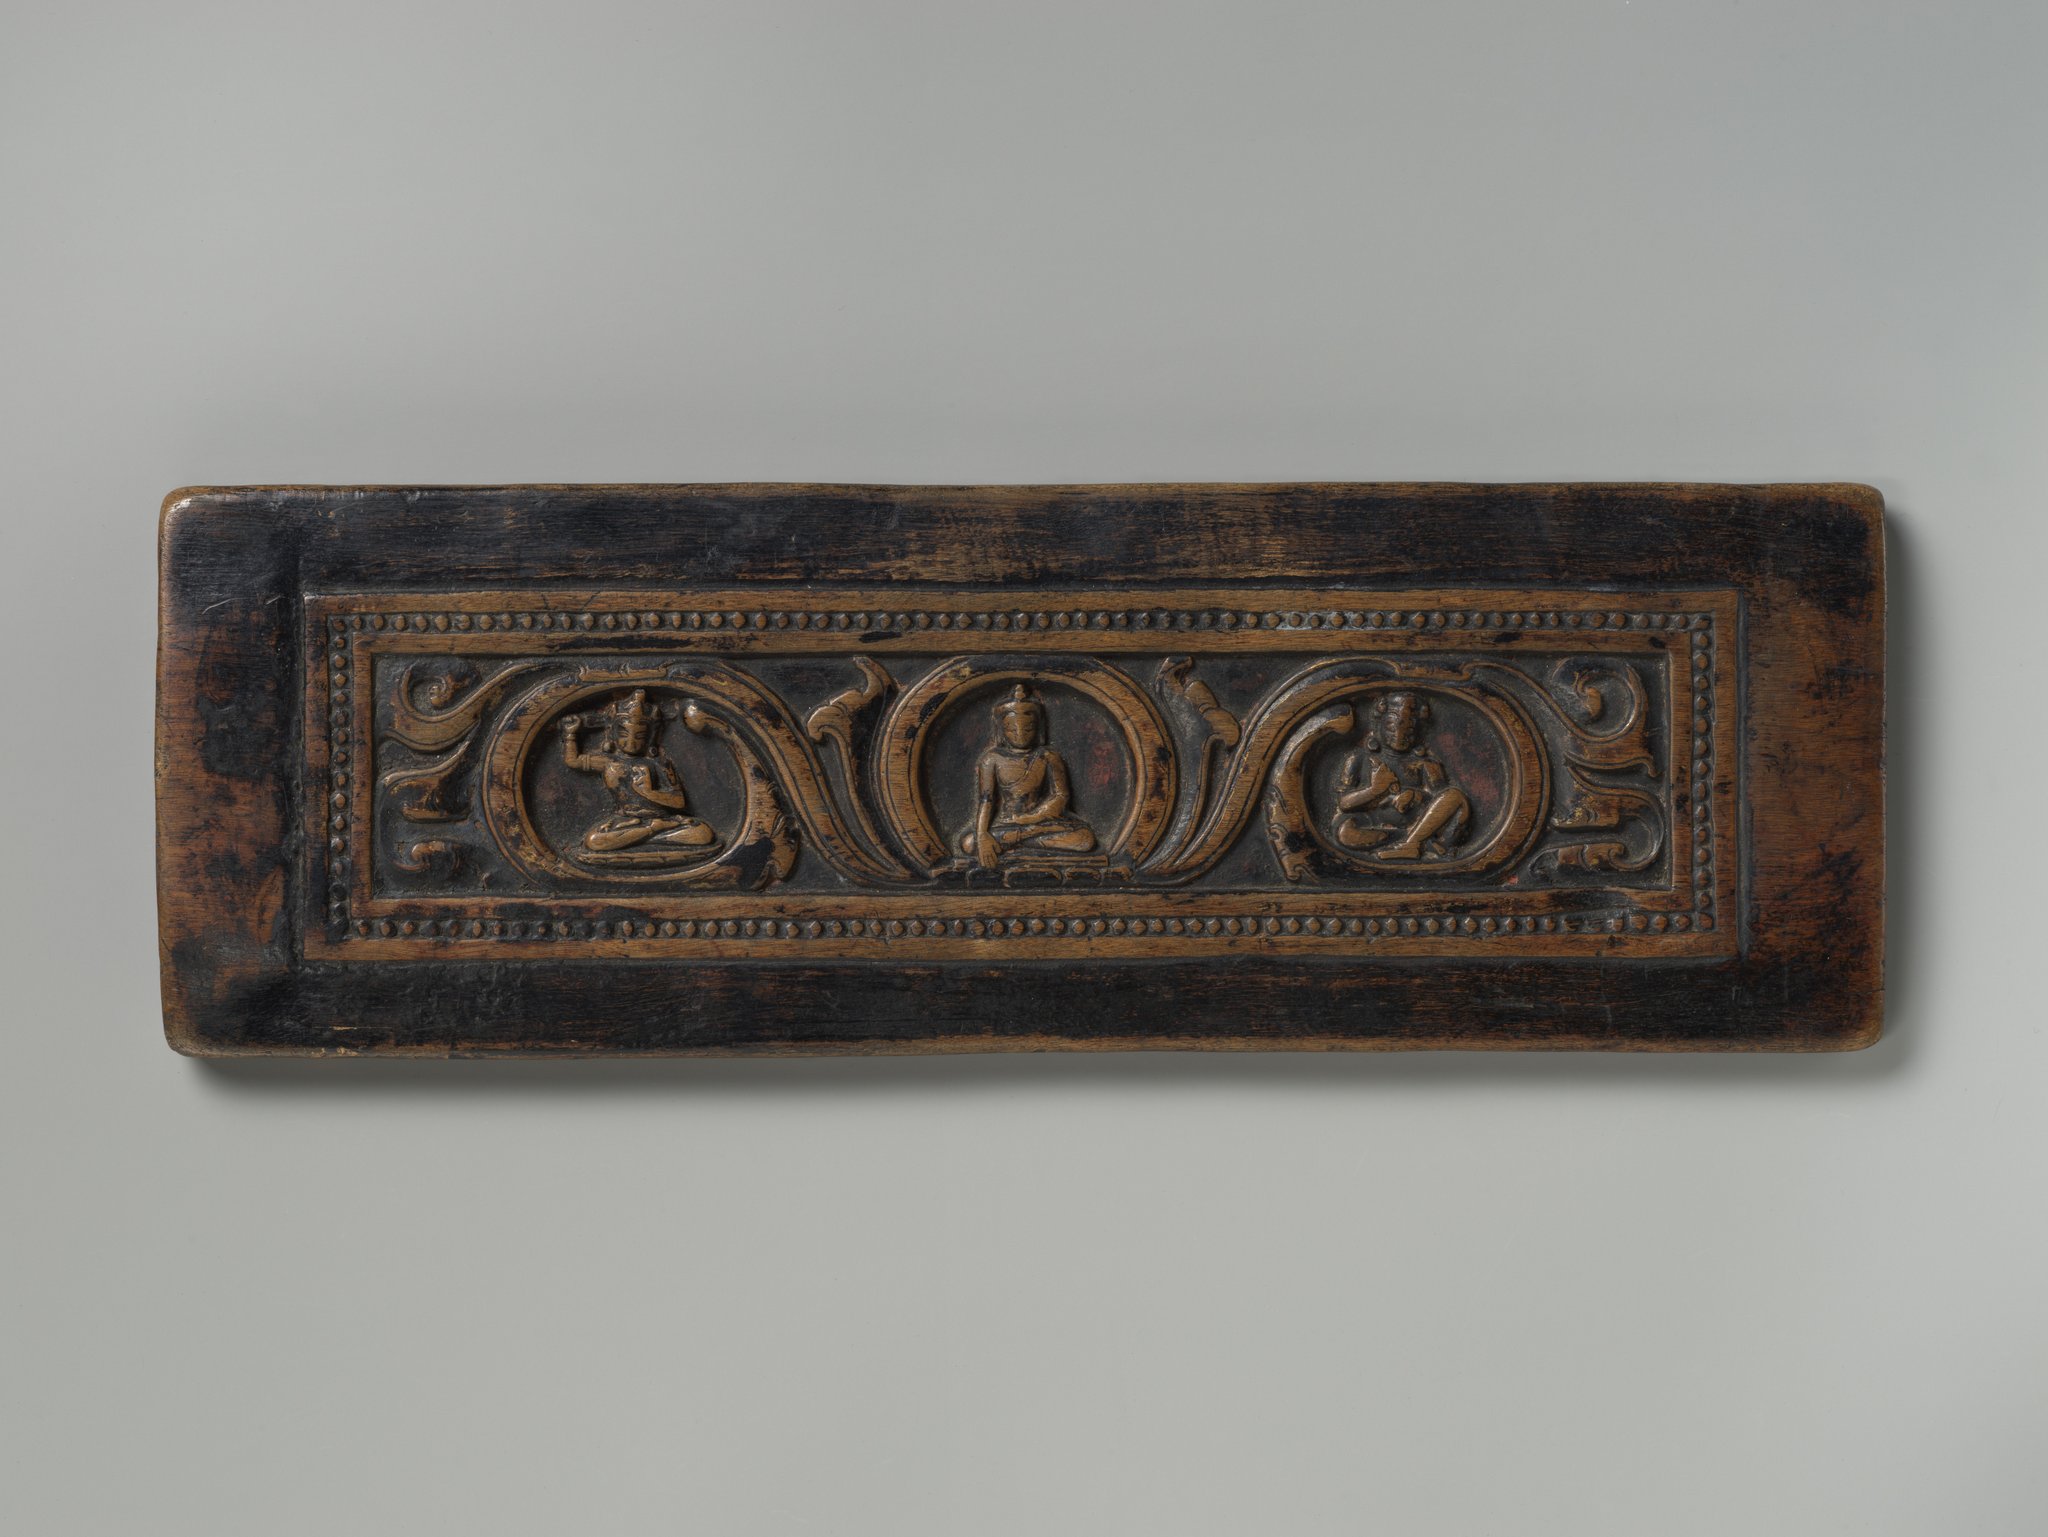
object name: manuscript cover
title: Manuscript Cover with the Buddha Shakyamuni, Attended by Manjushri and Vajrapani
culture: tibetan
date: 1101-1133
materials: paint, wood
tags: buddha,manjushri,shakyamuni,vajrapani